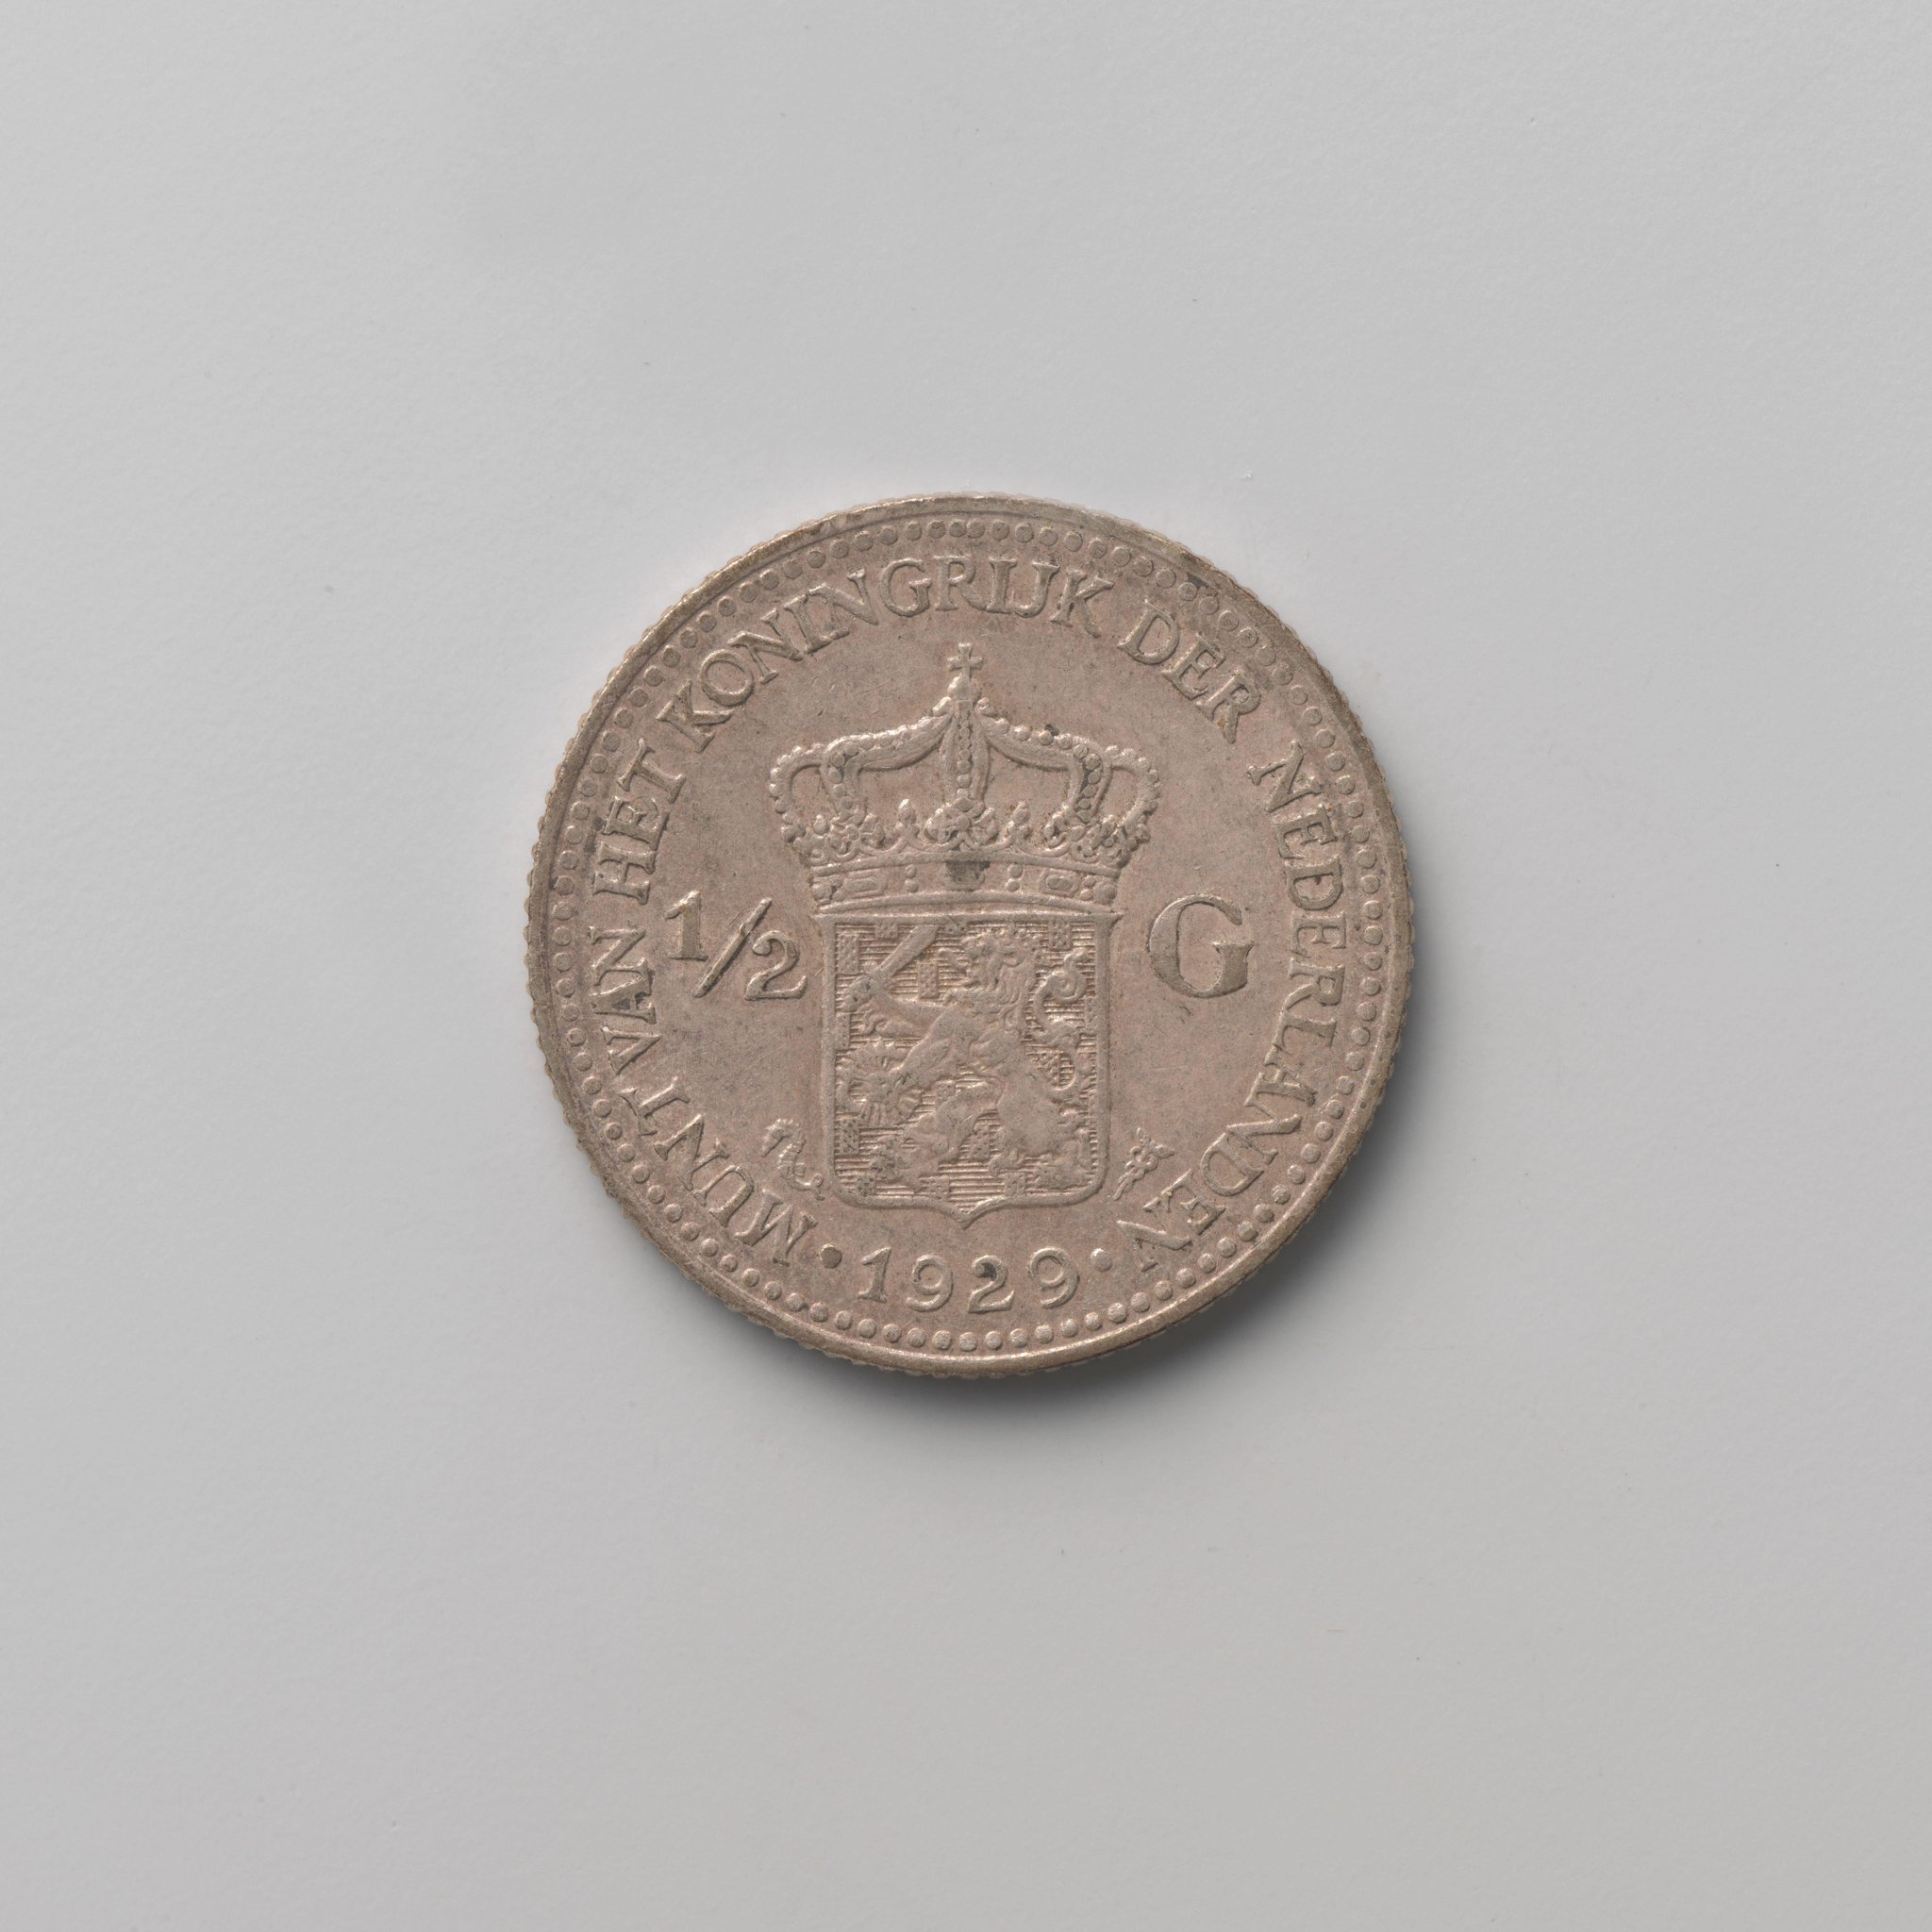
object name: halve gulden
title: Nederlandse ½ gulden,1929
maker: wilhelmina of the netherlands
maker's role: print maker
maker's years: 1880-1962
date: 1929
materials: silver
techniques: striking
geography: utrecht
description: Zilveren munt. Voorzijde: hoofd naar links. Keerzijde: tussen waarde-aanduiding ½ G gekroond rijkswapenschild. Jaartal onderaan in omschrift. Kartelrand.